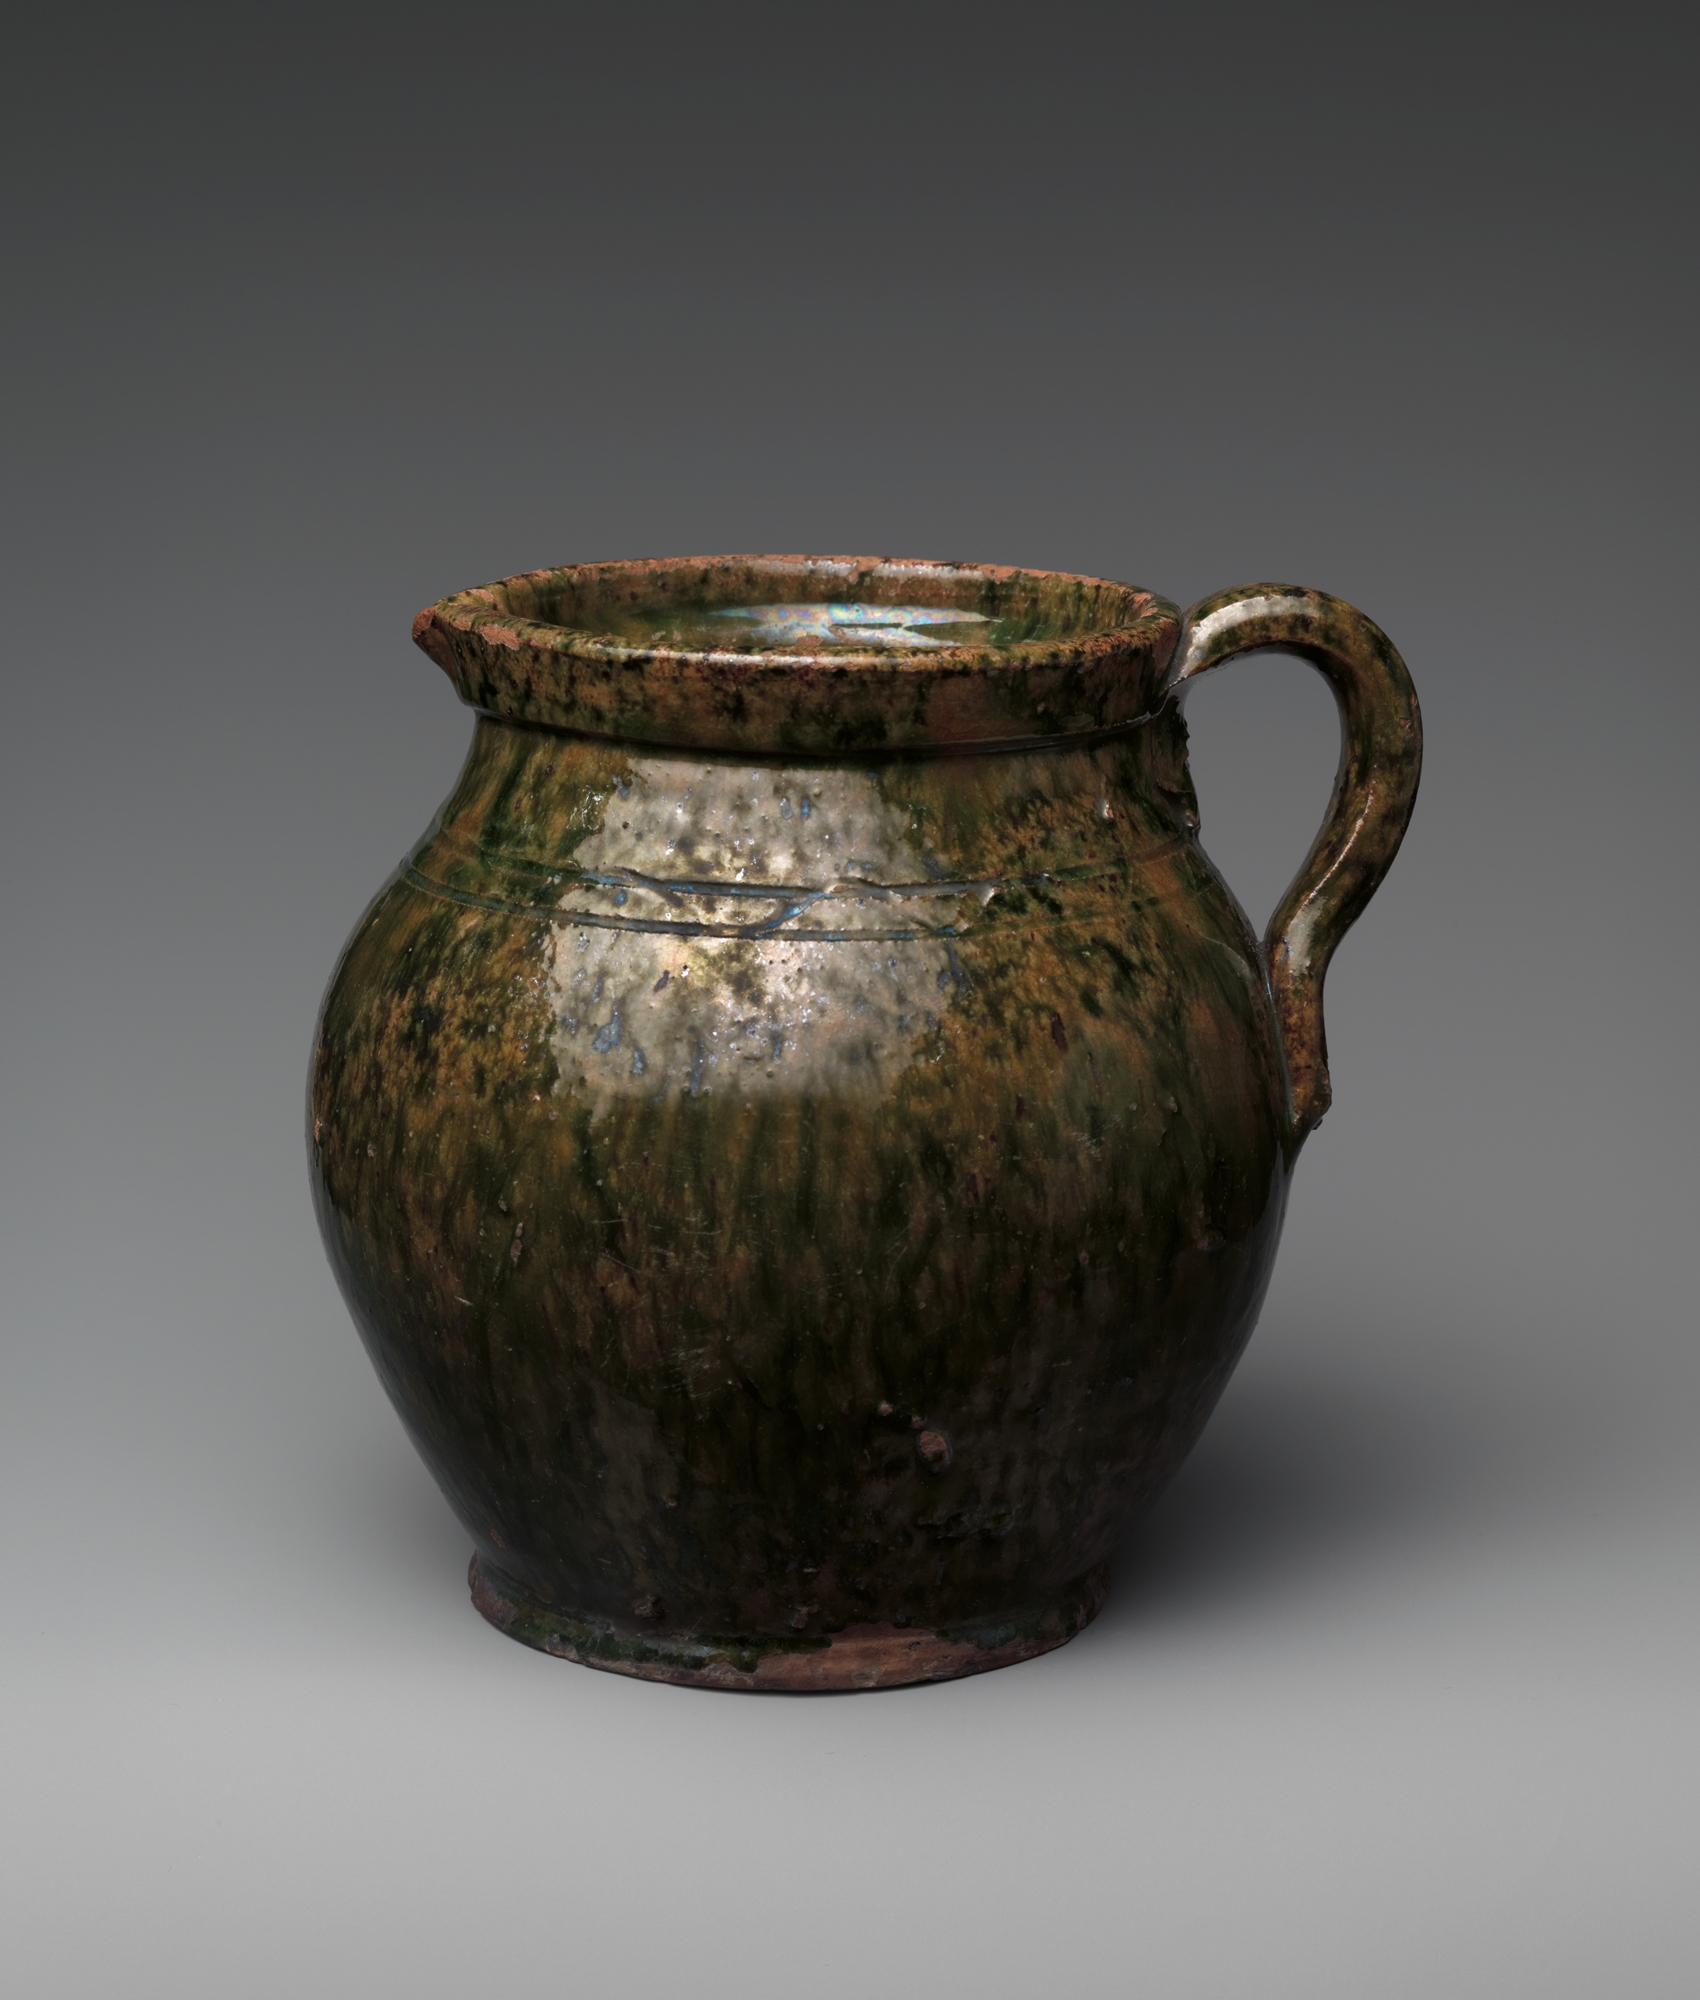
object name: pitcher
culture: american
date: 1800-1830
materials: earthenware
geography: united states